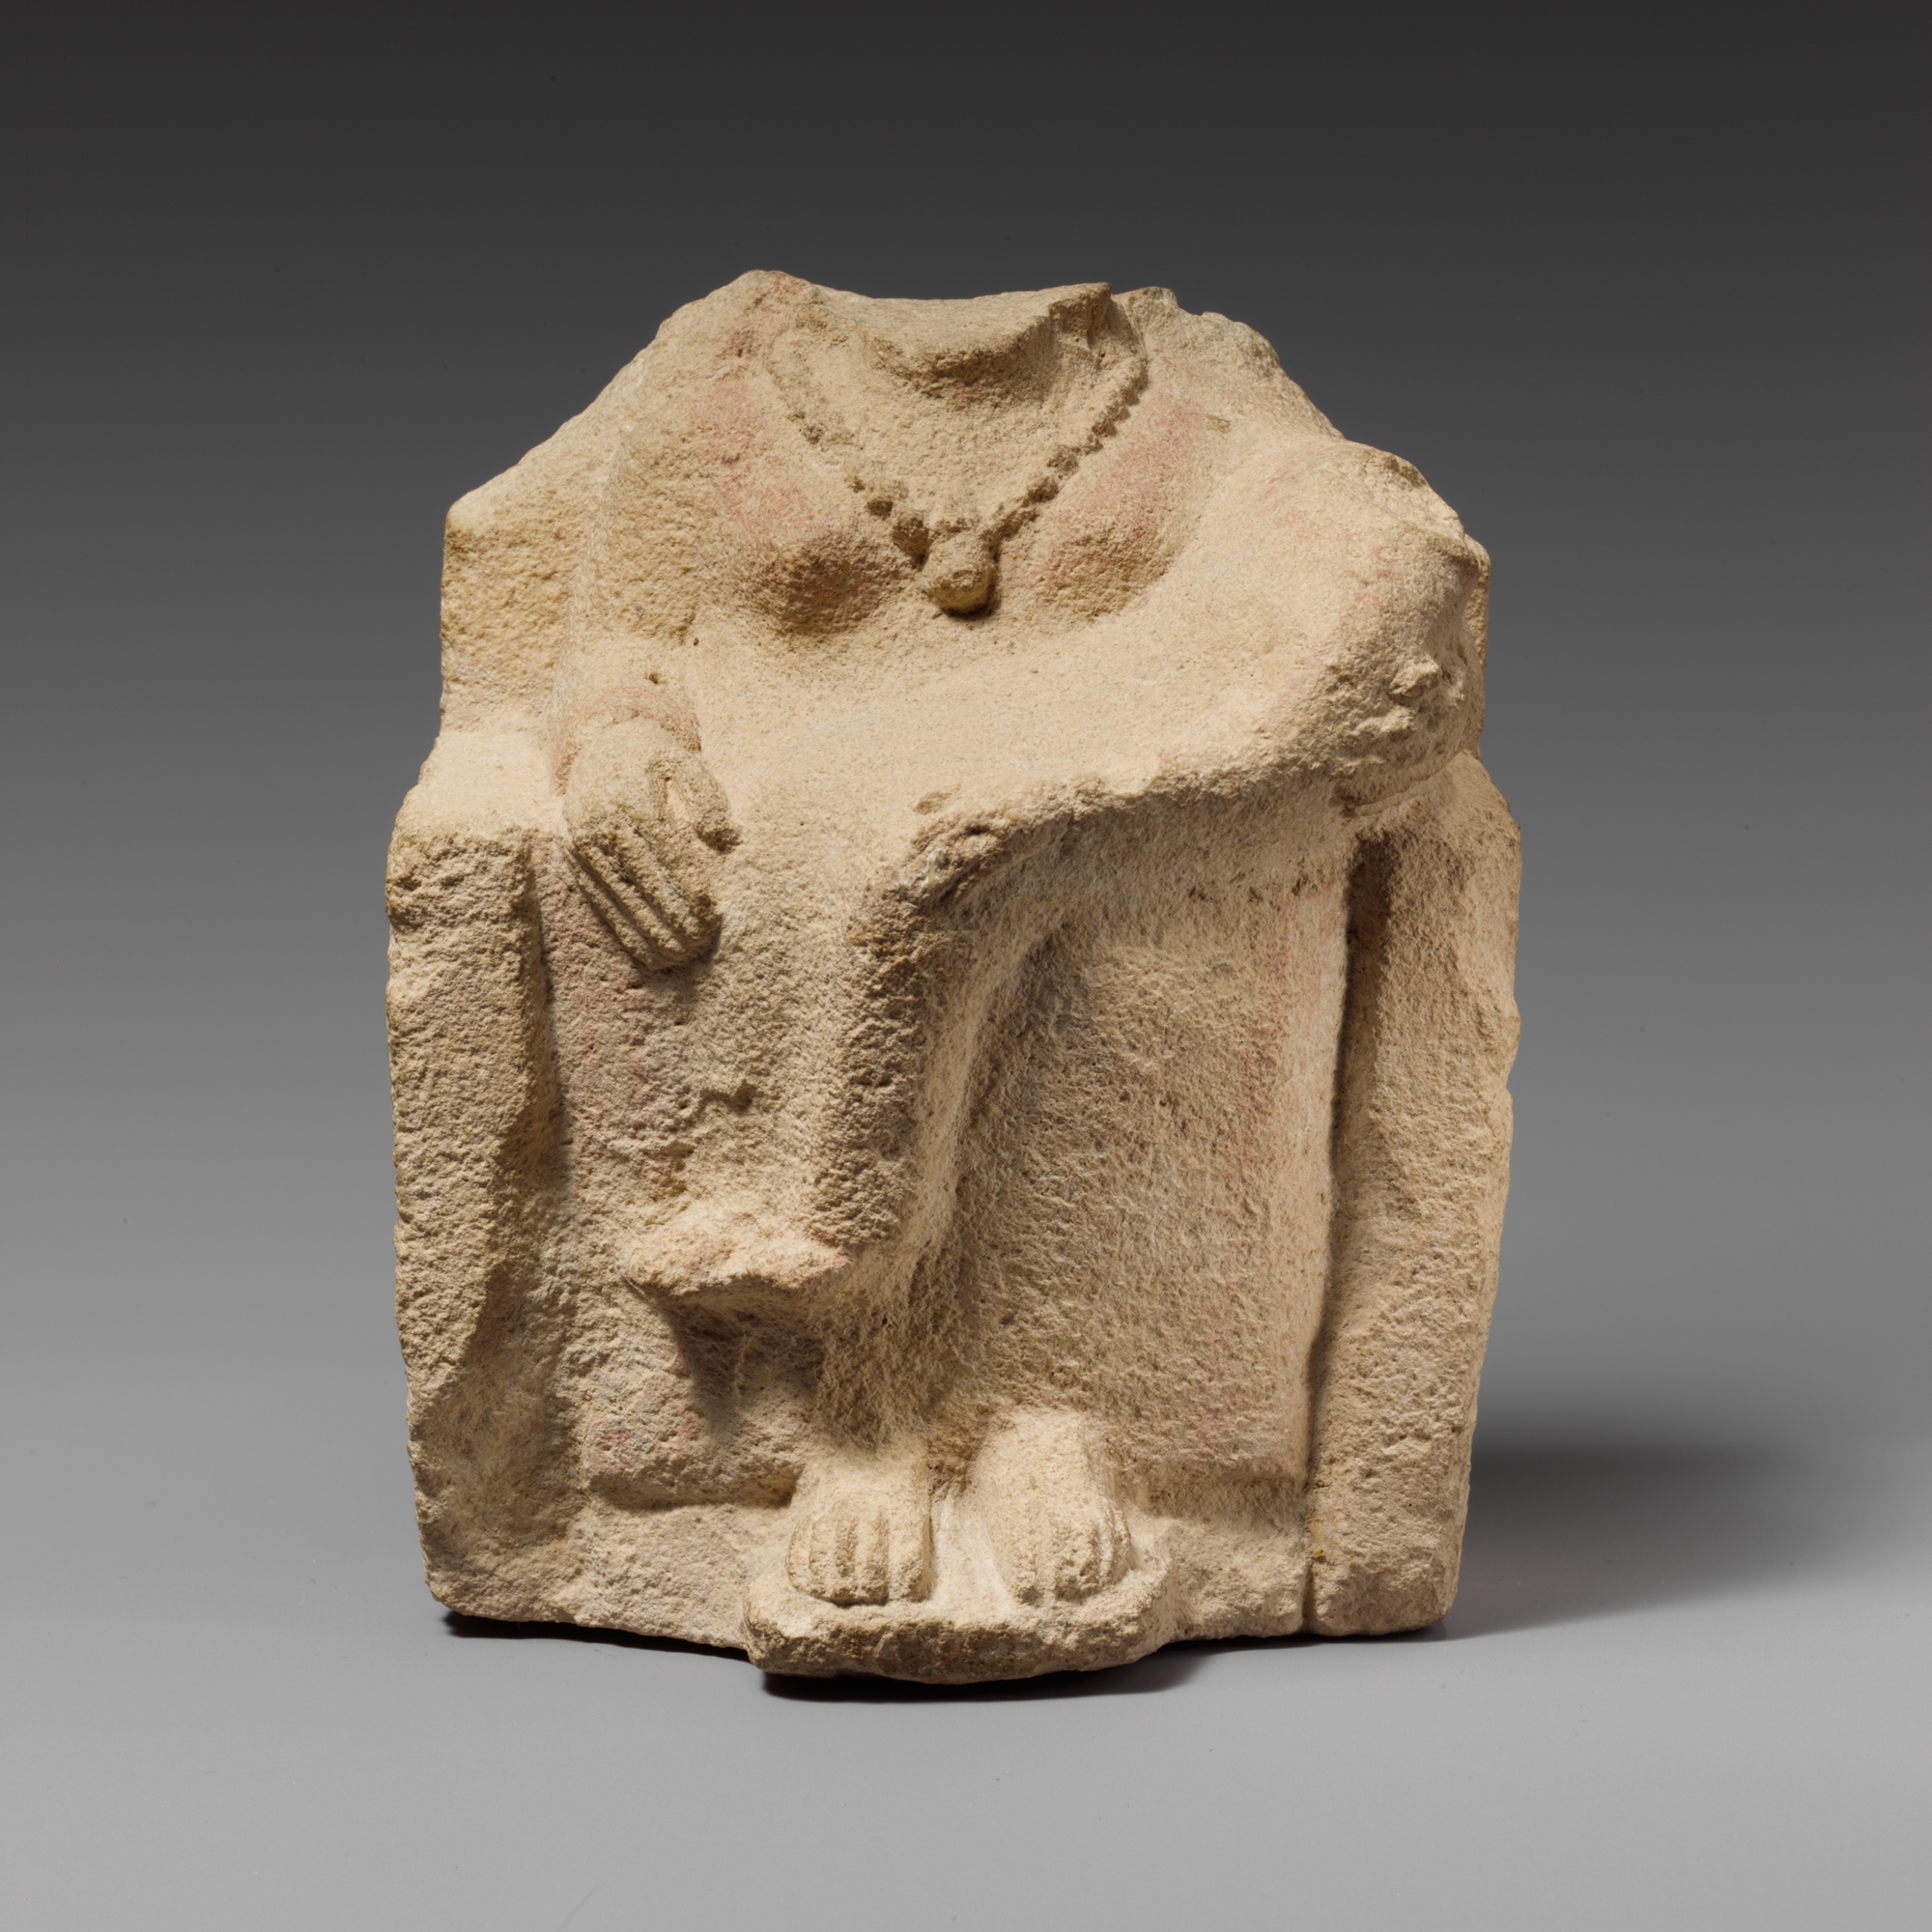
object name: statuette of a woman nursing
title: Seated limestone kourotrophos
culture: cypriot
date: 450-401 BCE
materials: limestone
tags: infants,women